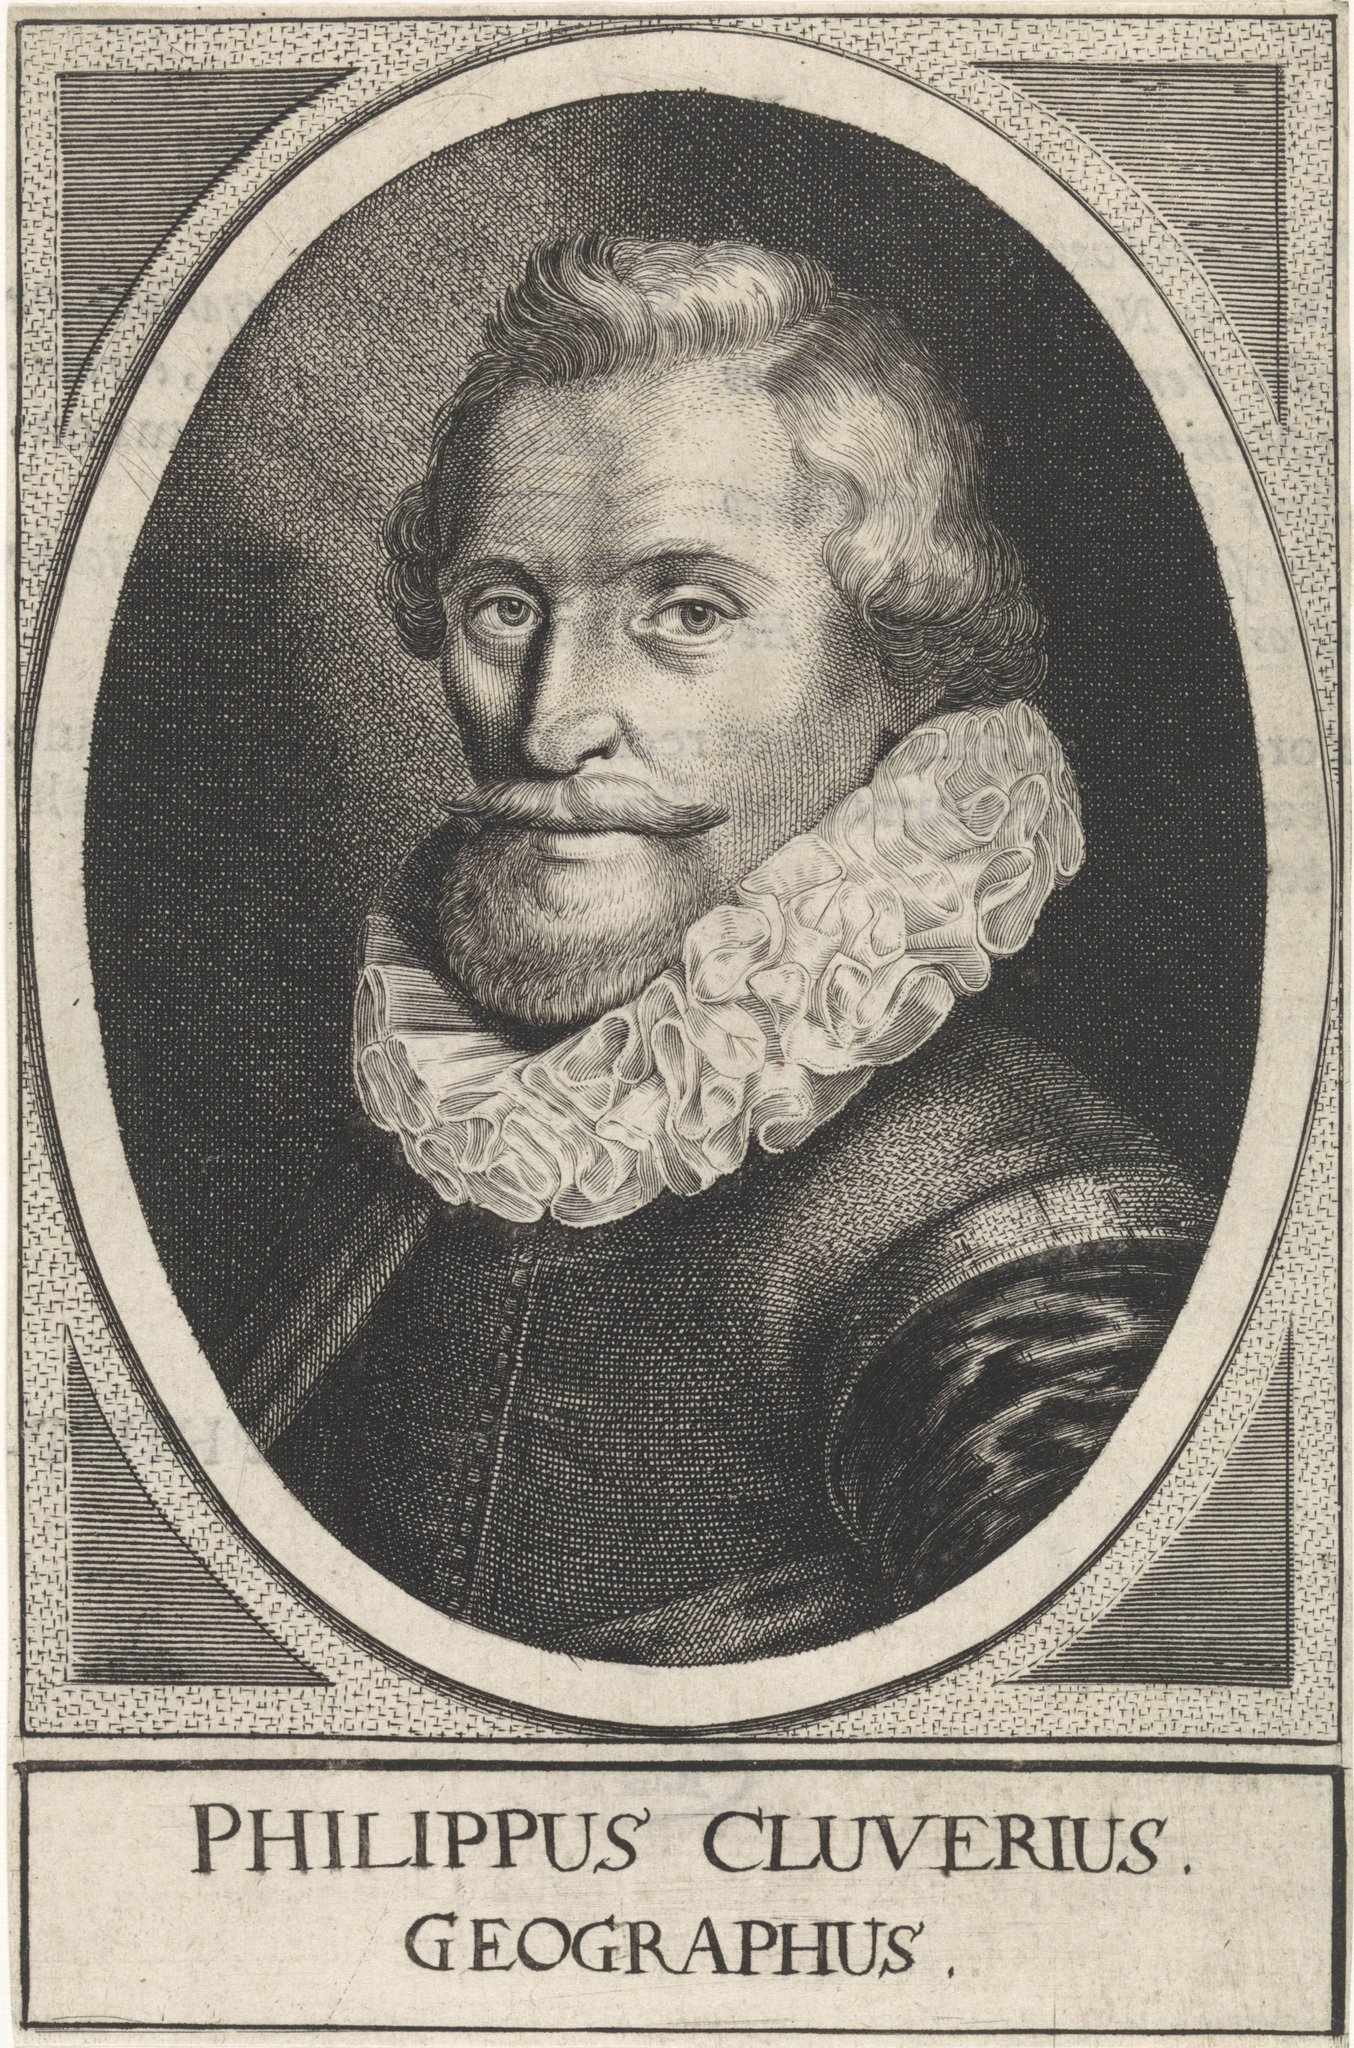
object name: print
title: Portret van Philipp Cluver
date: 1625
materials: paper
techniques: engraving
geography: leiden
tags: leiden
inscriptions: collector's mark: Lugt 964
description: Boekillustratie in: Meursius, Joannes. Athenæ Batavæ. Sive, De vrbe Leidensi, & academiâ, virisque claris. Leiden: Andries Clouck, Bonaventura en Abraham Elzevier, 1625. Abusievelijk tweemaal gecatalogiseerd bij Franken & Van der Kellen.